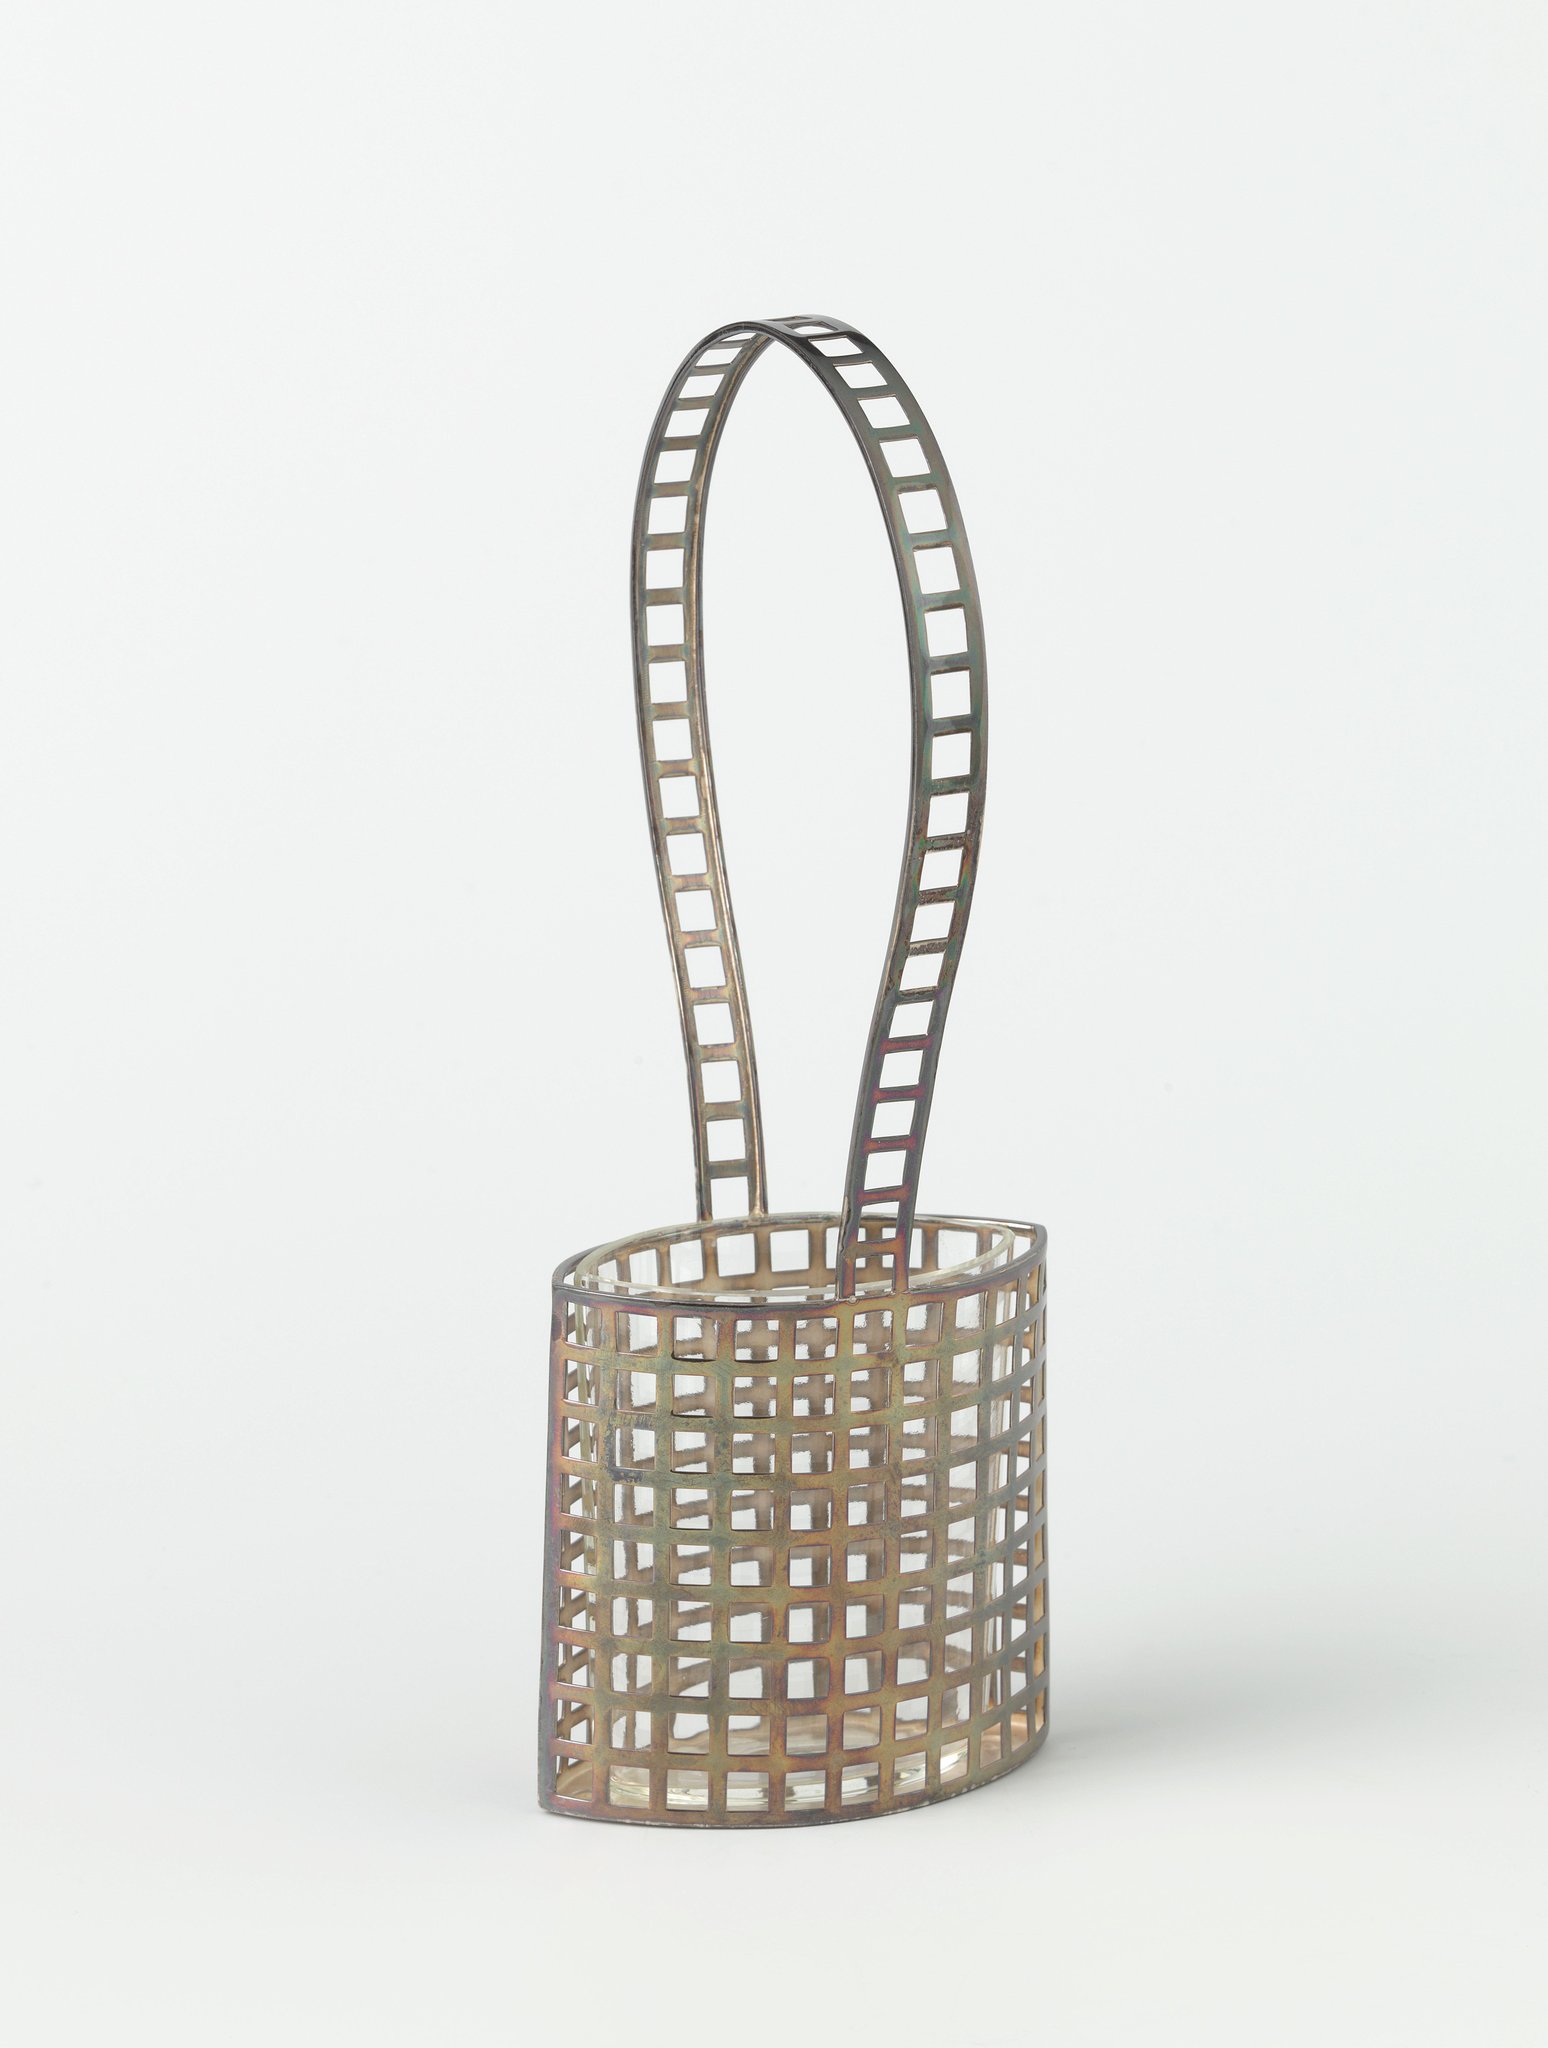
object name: binnenbak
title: Basket with Handle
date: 1905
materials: glass, silver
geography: vienna